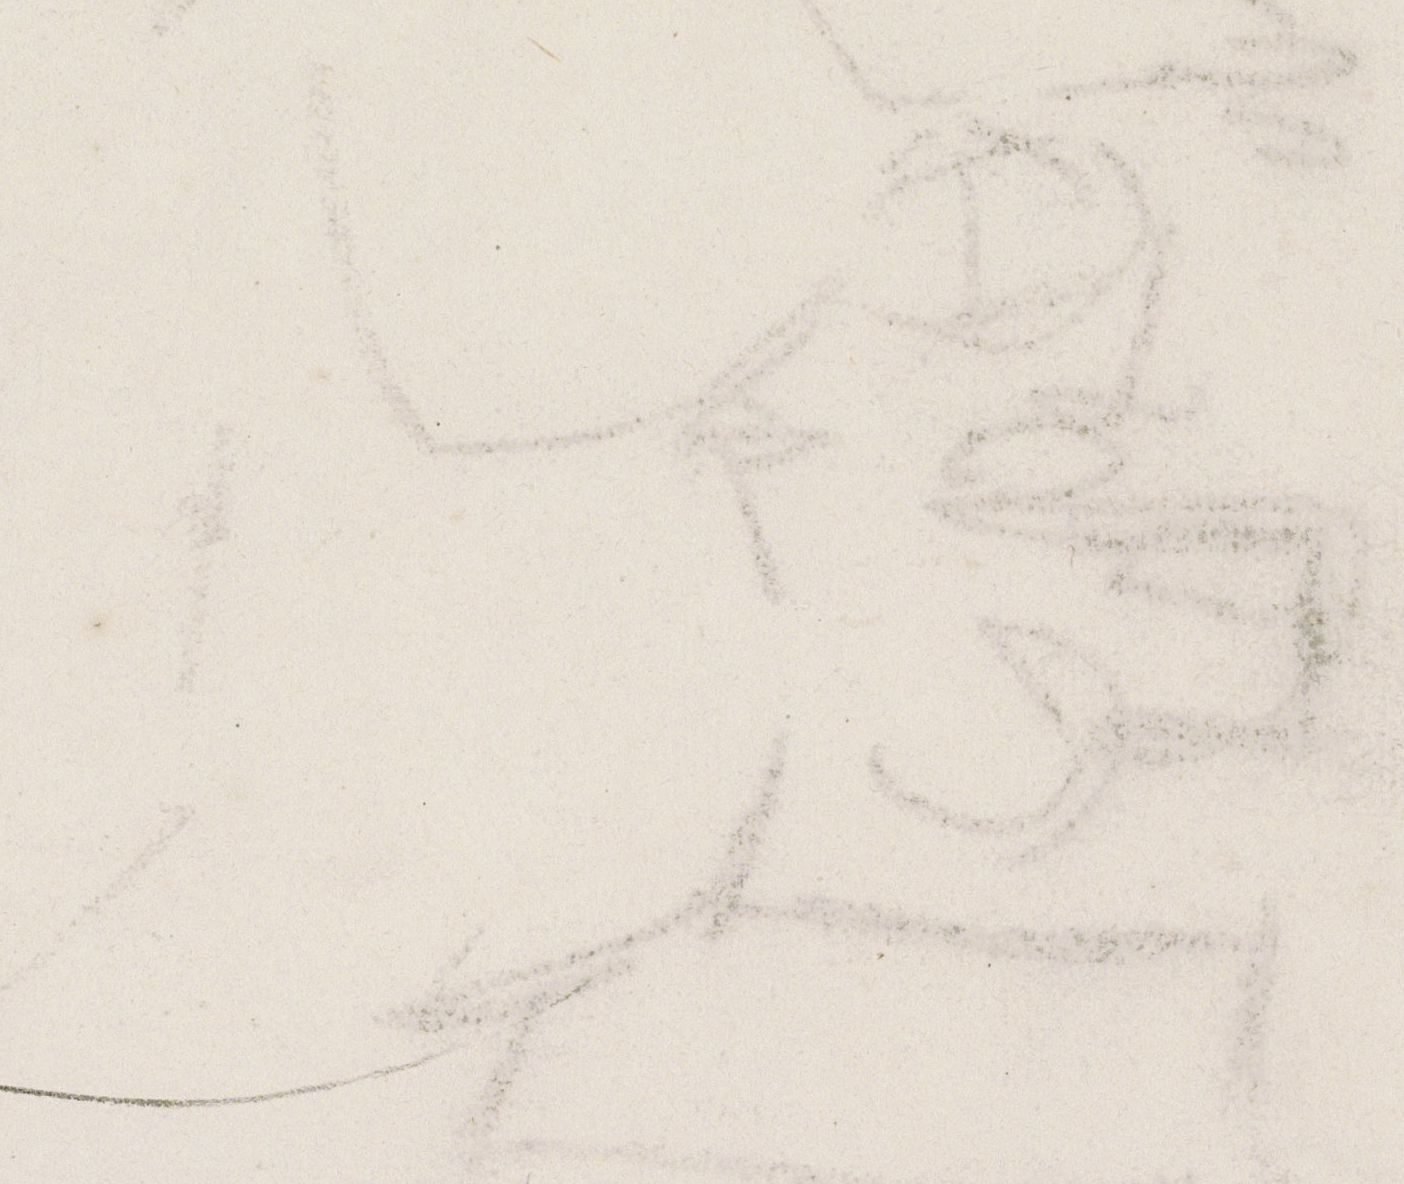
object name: sketchbook leaf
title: Abklatsch van een krijttekening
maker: isaac israels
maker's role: draughtsman, painter, print maker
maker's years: 1865-1934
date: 1886-1934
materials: paper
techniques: printmaking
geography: amsterdam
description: De originele tekening met figuurstudies is niet meer in het schetsboek aanwezig. Blad 2 recto uit schetsboek LIV met 18 bladen.